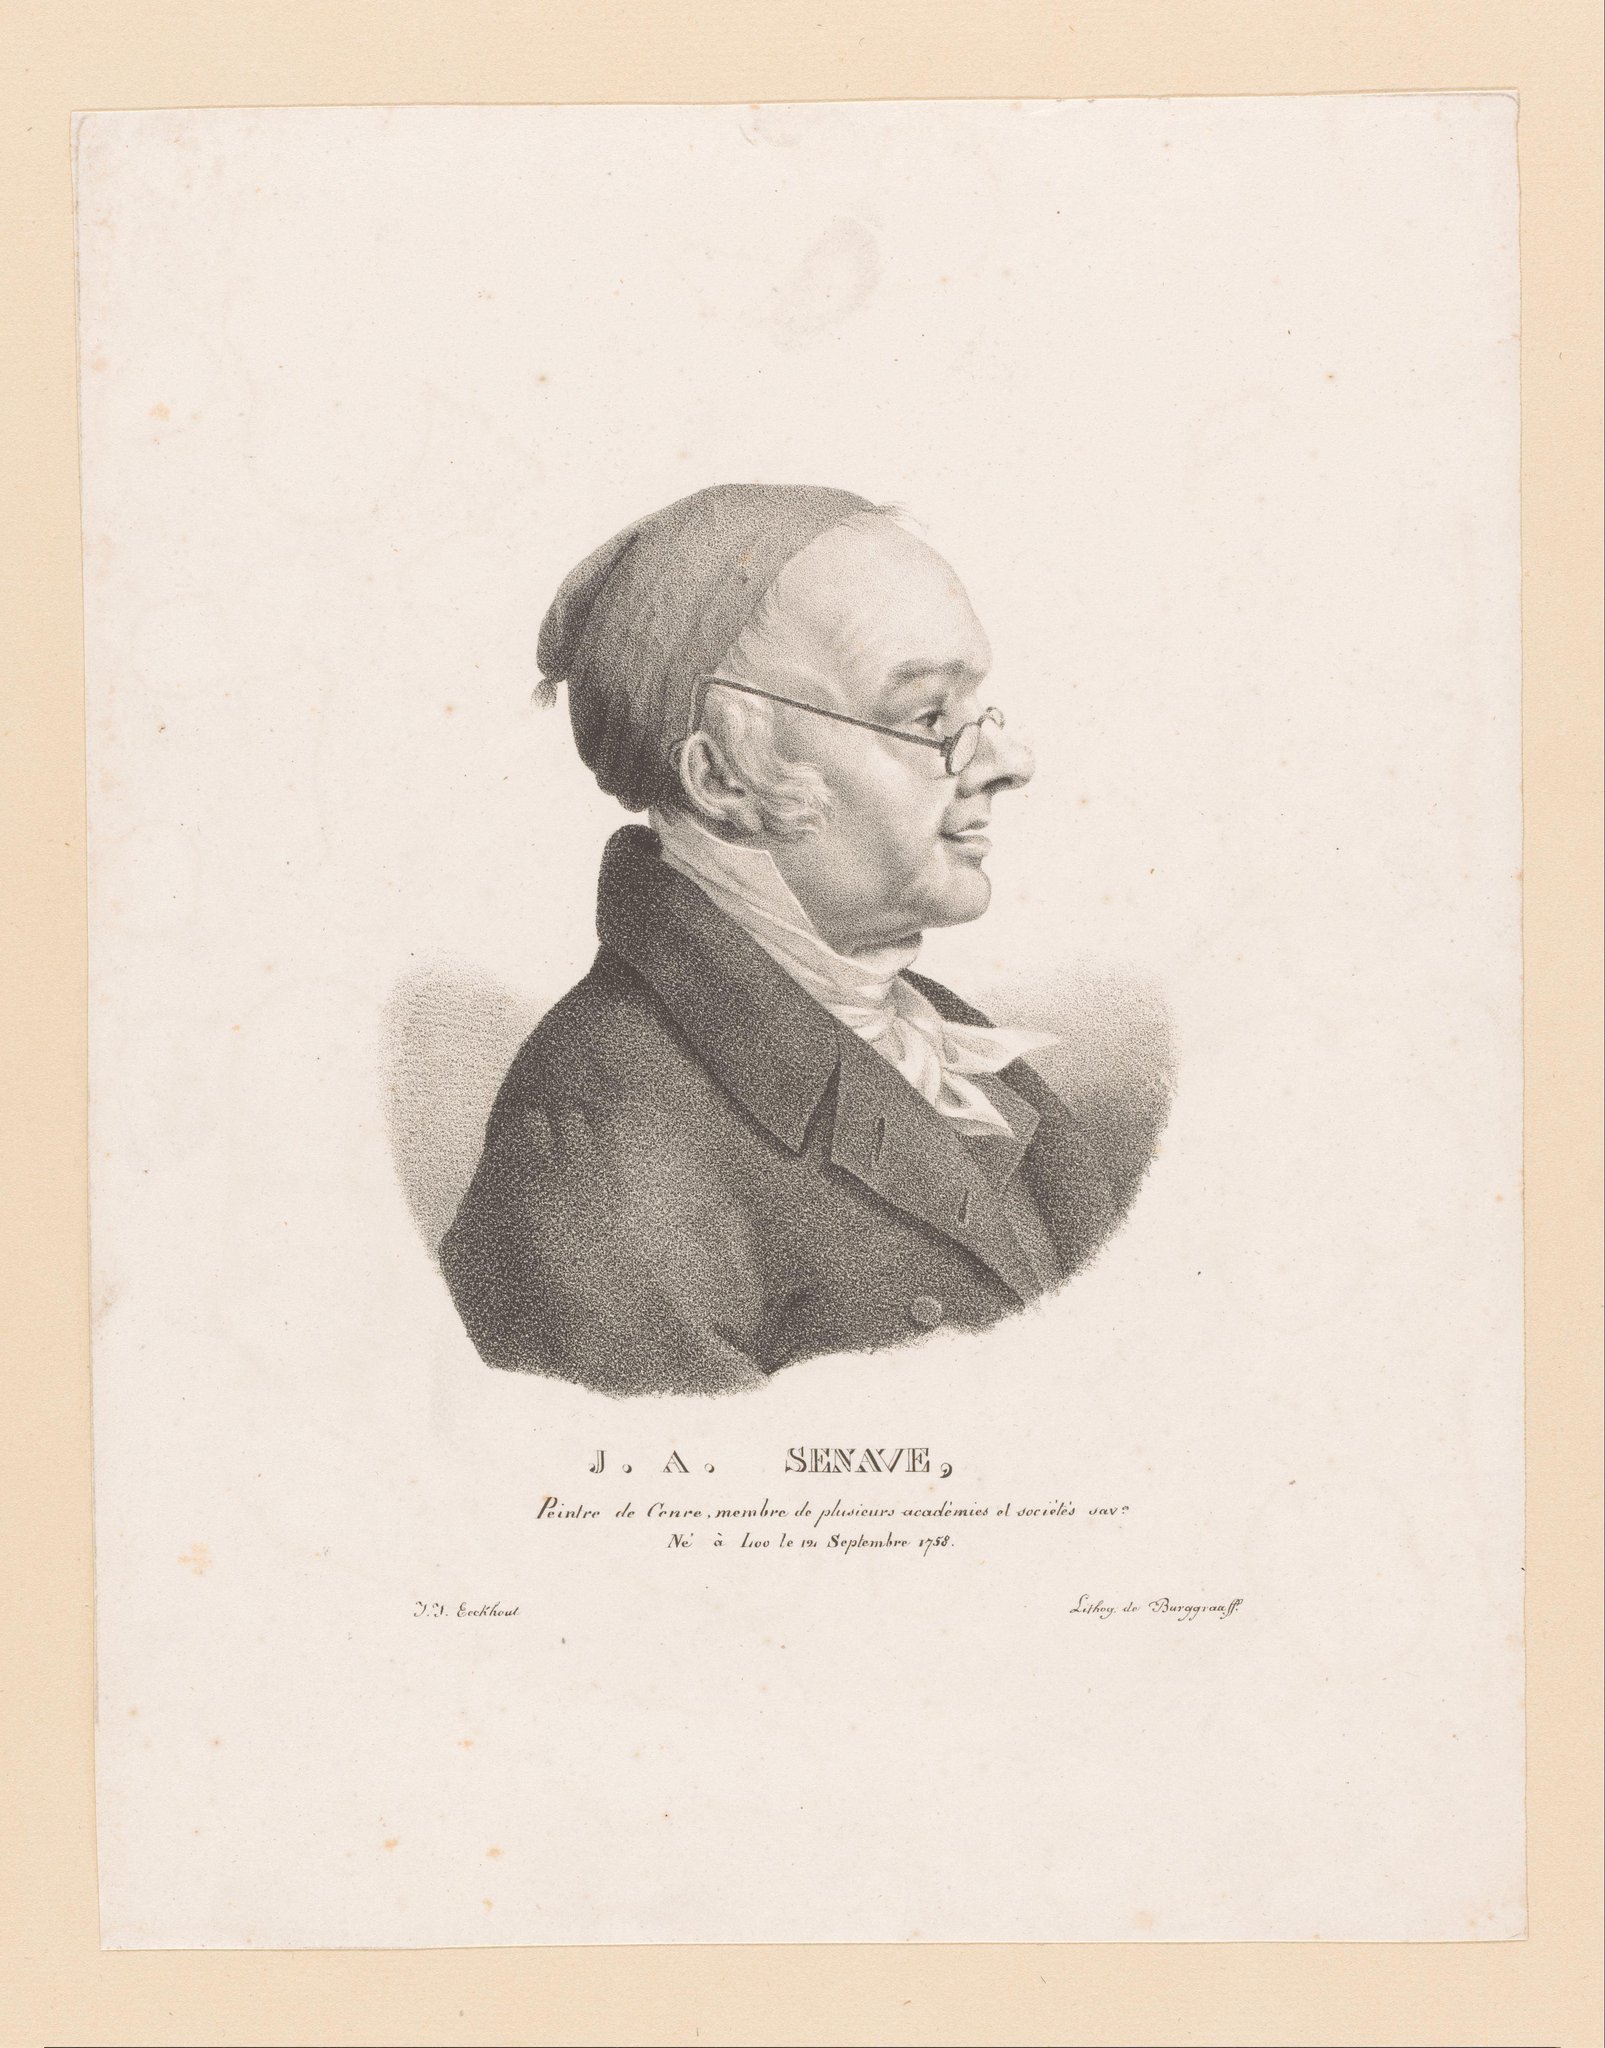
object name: print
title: Portretten van hedendaagse kunstenaars uit het Verenigd Koninkrijk der Nederlanden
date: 1822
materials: paper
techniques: lithograph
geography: brussels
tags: paris, painter, jacques albert sénave, historical persons, portrait, self-portrait of painter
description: Prent maakt deel uit van een serie van zestig prenten.